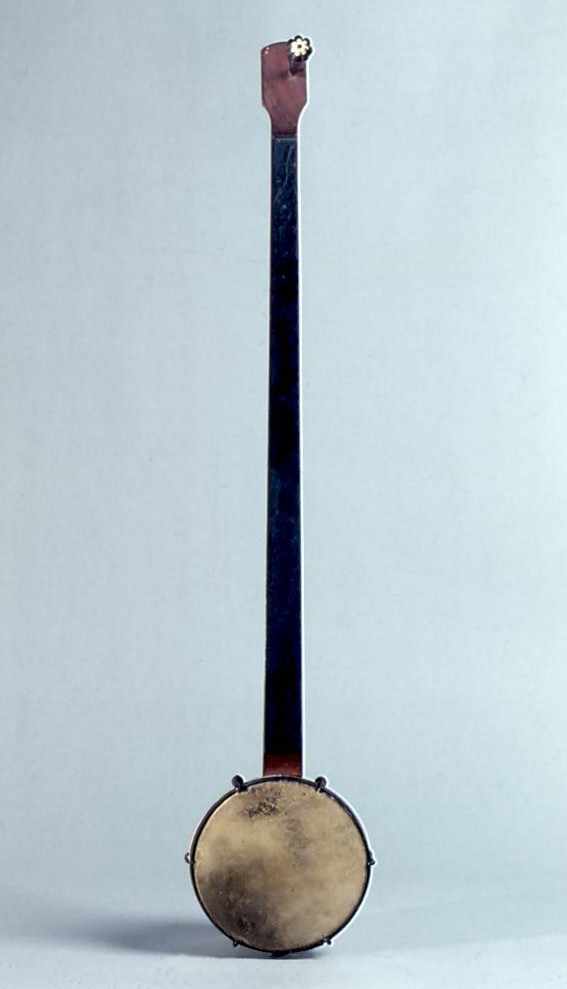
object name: japanese fiddle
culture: american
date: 1867-1900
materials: metal, skin, wood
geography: united states